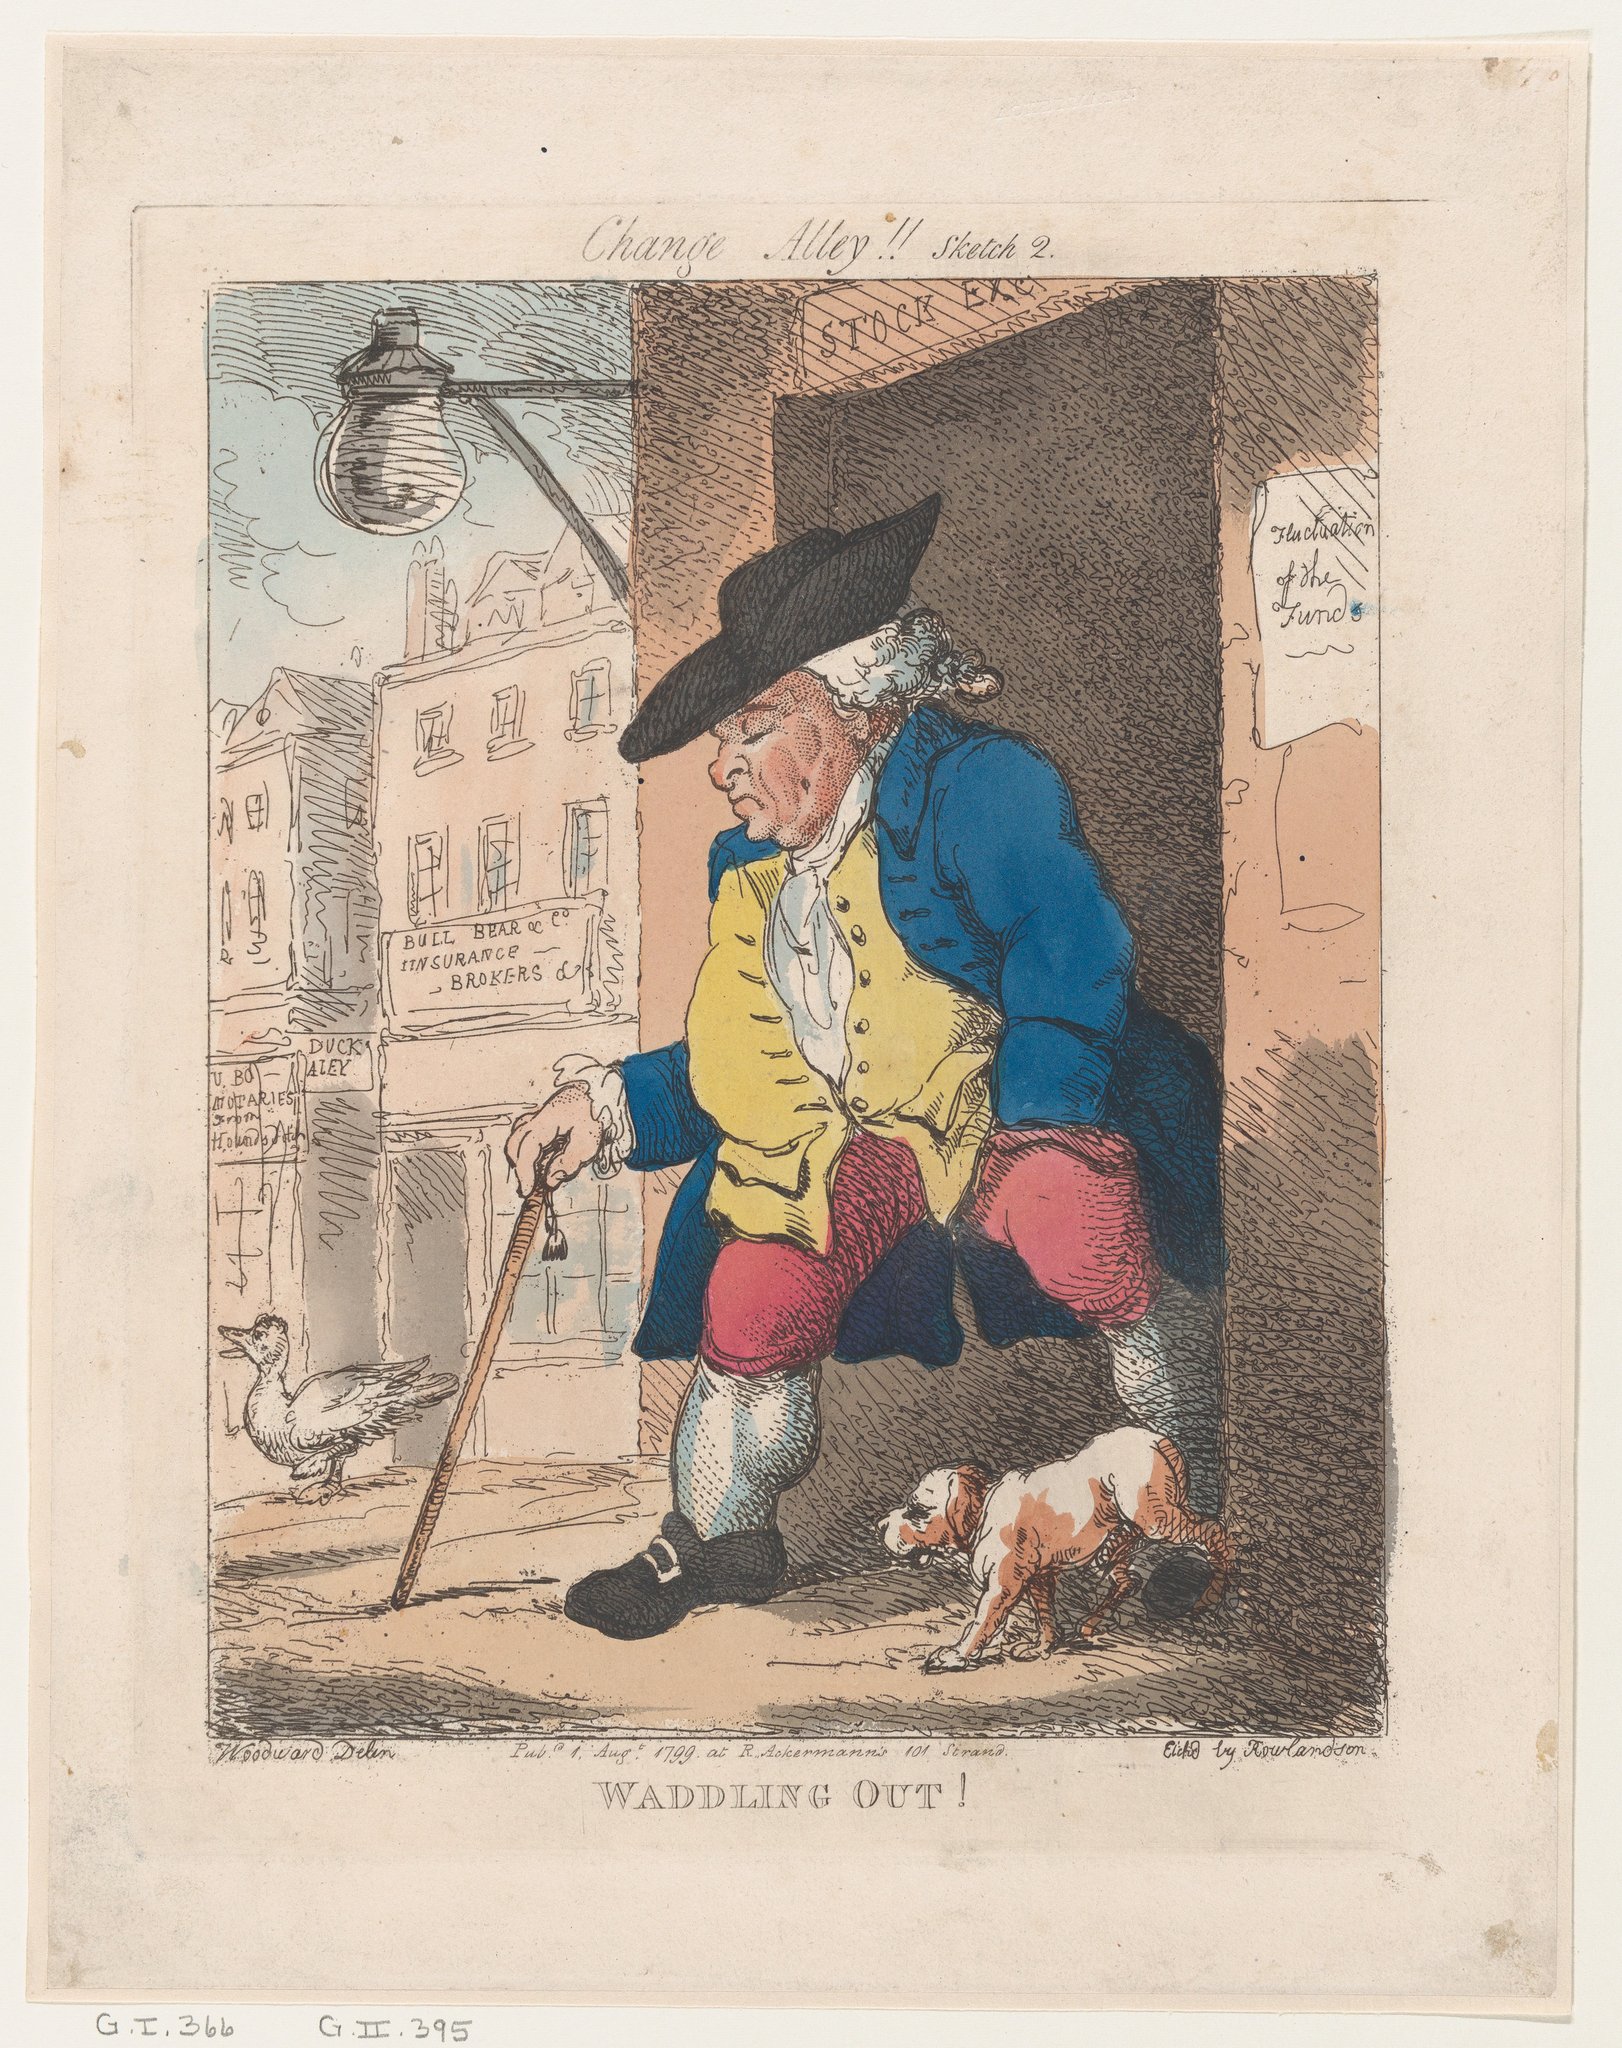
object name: print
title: Waddling Out!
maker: thomas rowlandson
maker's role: artist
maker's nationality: british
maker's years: 1757-1827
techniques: etching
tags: birds,buildings,men,dogs